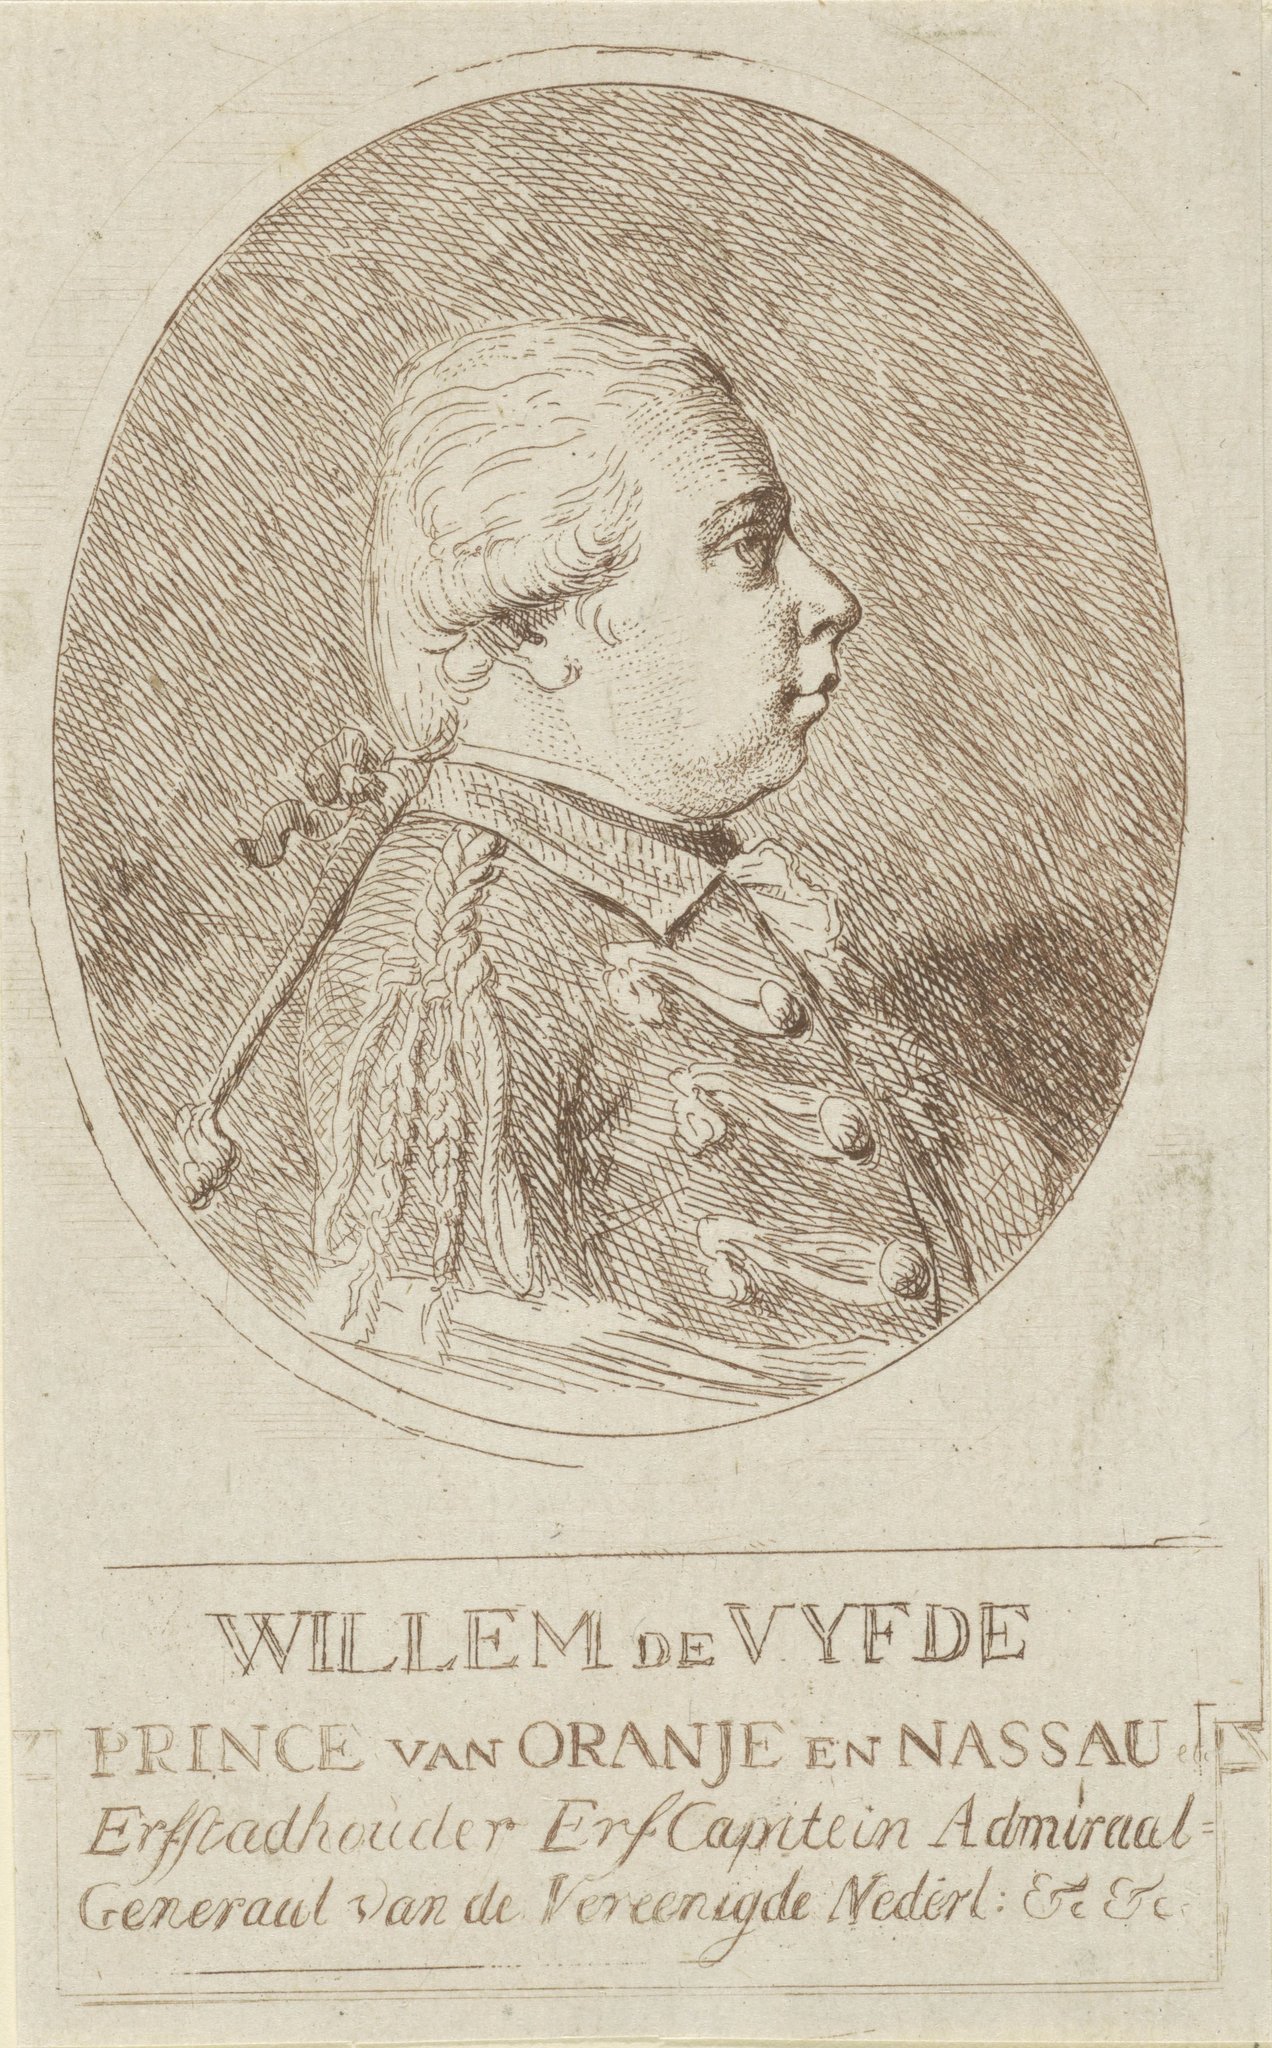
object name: print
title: Portret van Willem V, prins van Oranje-Nassau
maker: Anonymous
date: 1775-1849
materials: paper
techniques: etching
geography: low countries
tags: william v (prince of orange)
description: De hier vermelde titel verwijst naar de hoogst verkregen titel van de geportretteerde, niet per se naar de titel die de geportretteerde op deze voorstelling draagt.